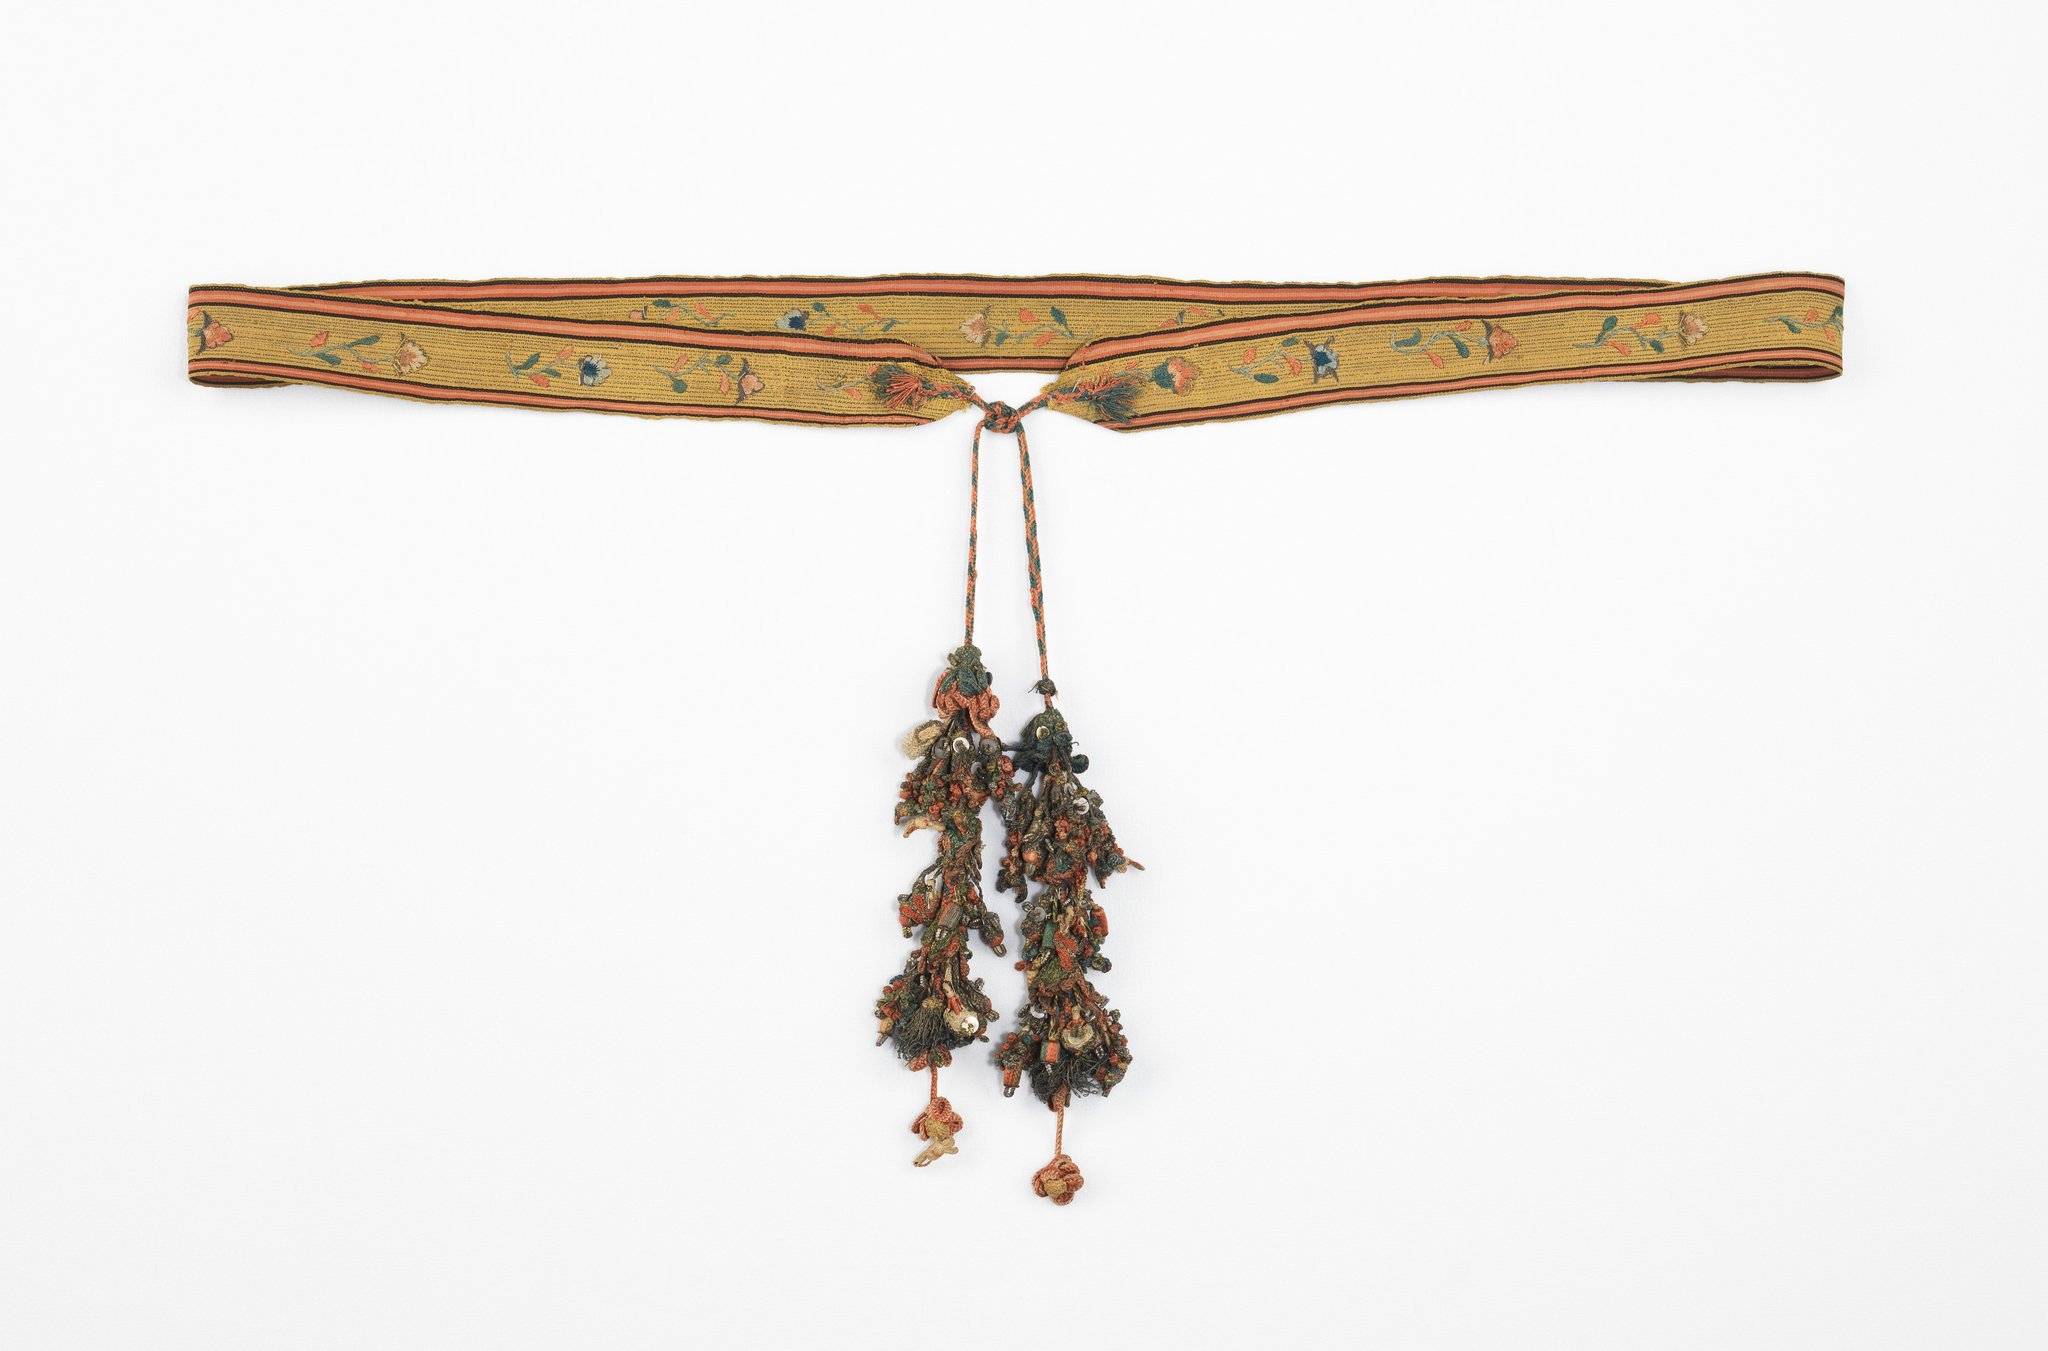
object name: belt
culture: european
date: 1700-1709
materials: metal, silk